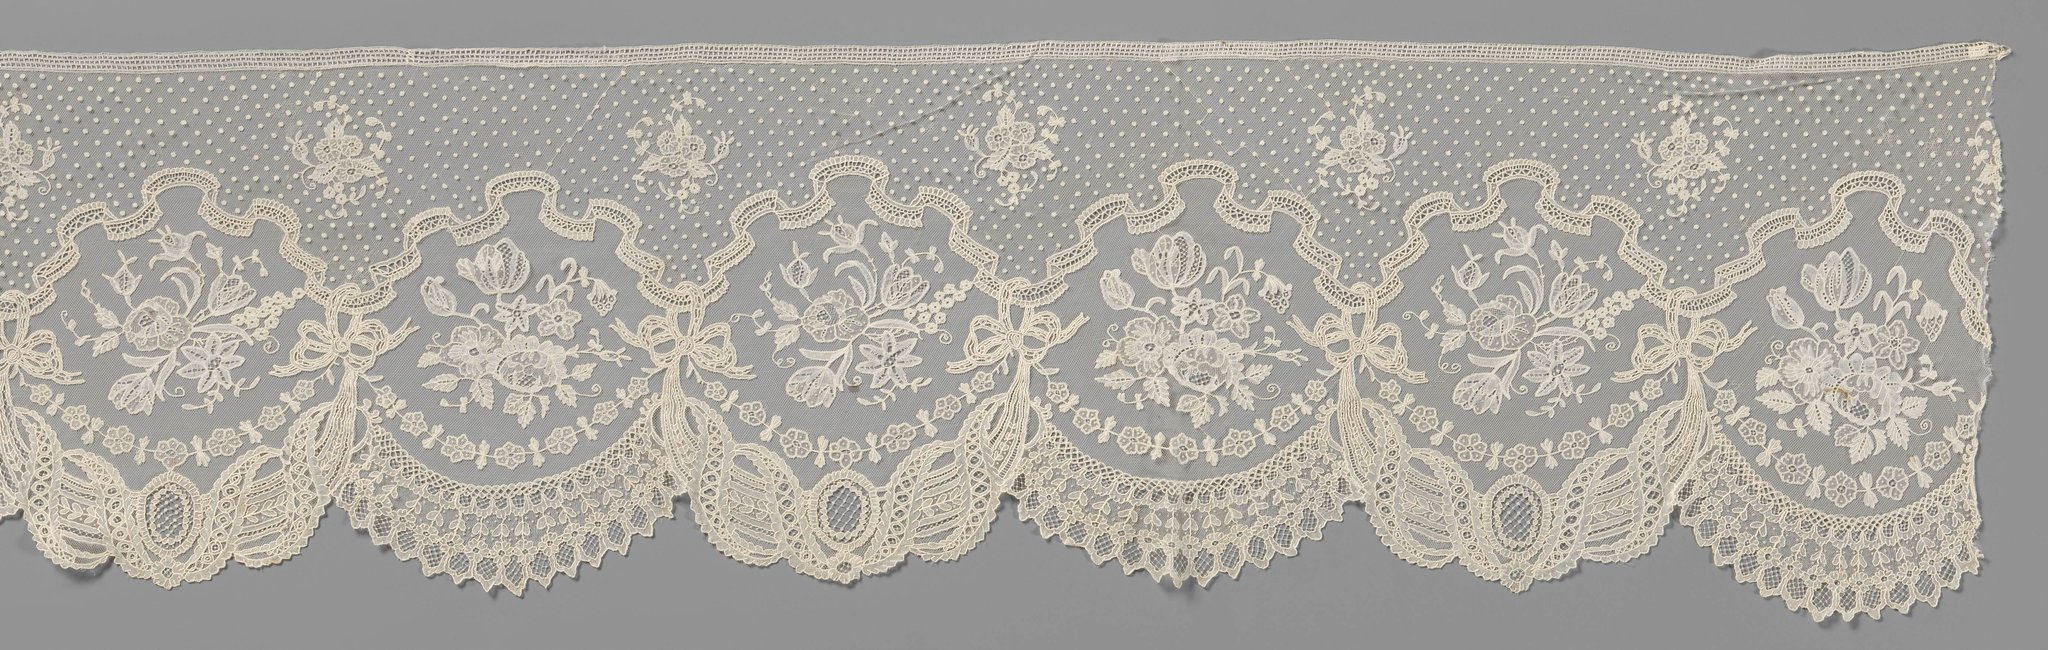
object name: japonstrook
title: Strook van applicatiekant met bijou op de slingers voor een crinoline-japon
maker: Anonymous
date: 1850-1860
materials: linen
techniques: lace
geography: brussels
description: Strook naturelkleurige Brusselse applicatiekant: gemengde kant - Brusselse gaaskant en kloskant- geappliceerd op machinale tule. De strook is bedoeld of gebruikt als versiering aan een crinoline-japon. Twee afwisselende typen van ronde schulpen vormen samen met een kanten banderolle een aaneenschakeling van grote ronde reserves, waarboven een met moesjes bezaaide grond. De reserves zijn telkens met een boeket of roos gevuld (kloskant). De ene schulp vertoont een met een staand ovaal bijou versierd lint, dat met een strik is opgehangen aan de banderolle en met een geschulpt lintje is omwonden. De andere schulp vertoont uitstralende takjes met rozetjes tussen twee rijen van campanes. Boven de reserves staan kleine boeketjes. De bovenzijde van de strook is afgewerkt met een apart geklost bandje.